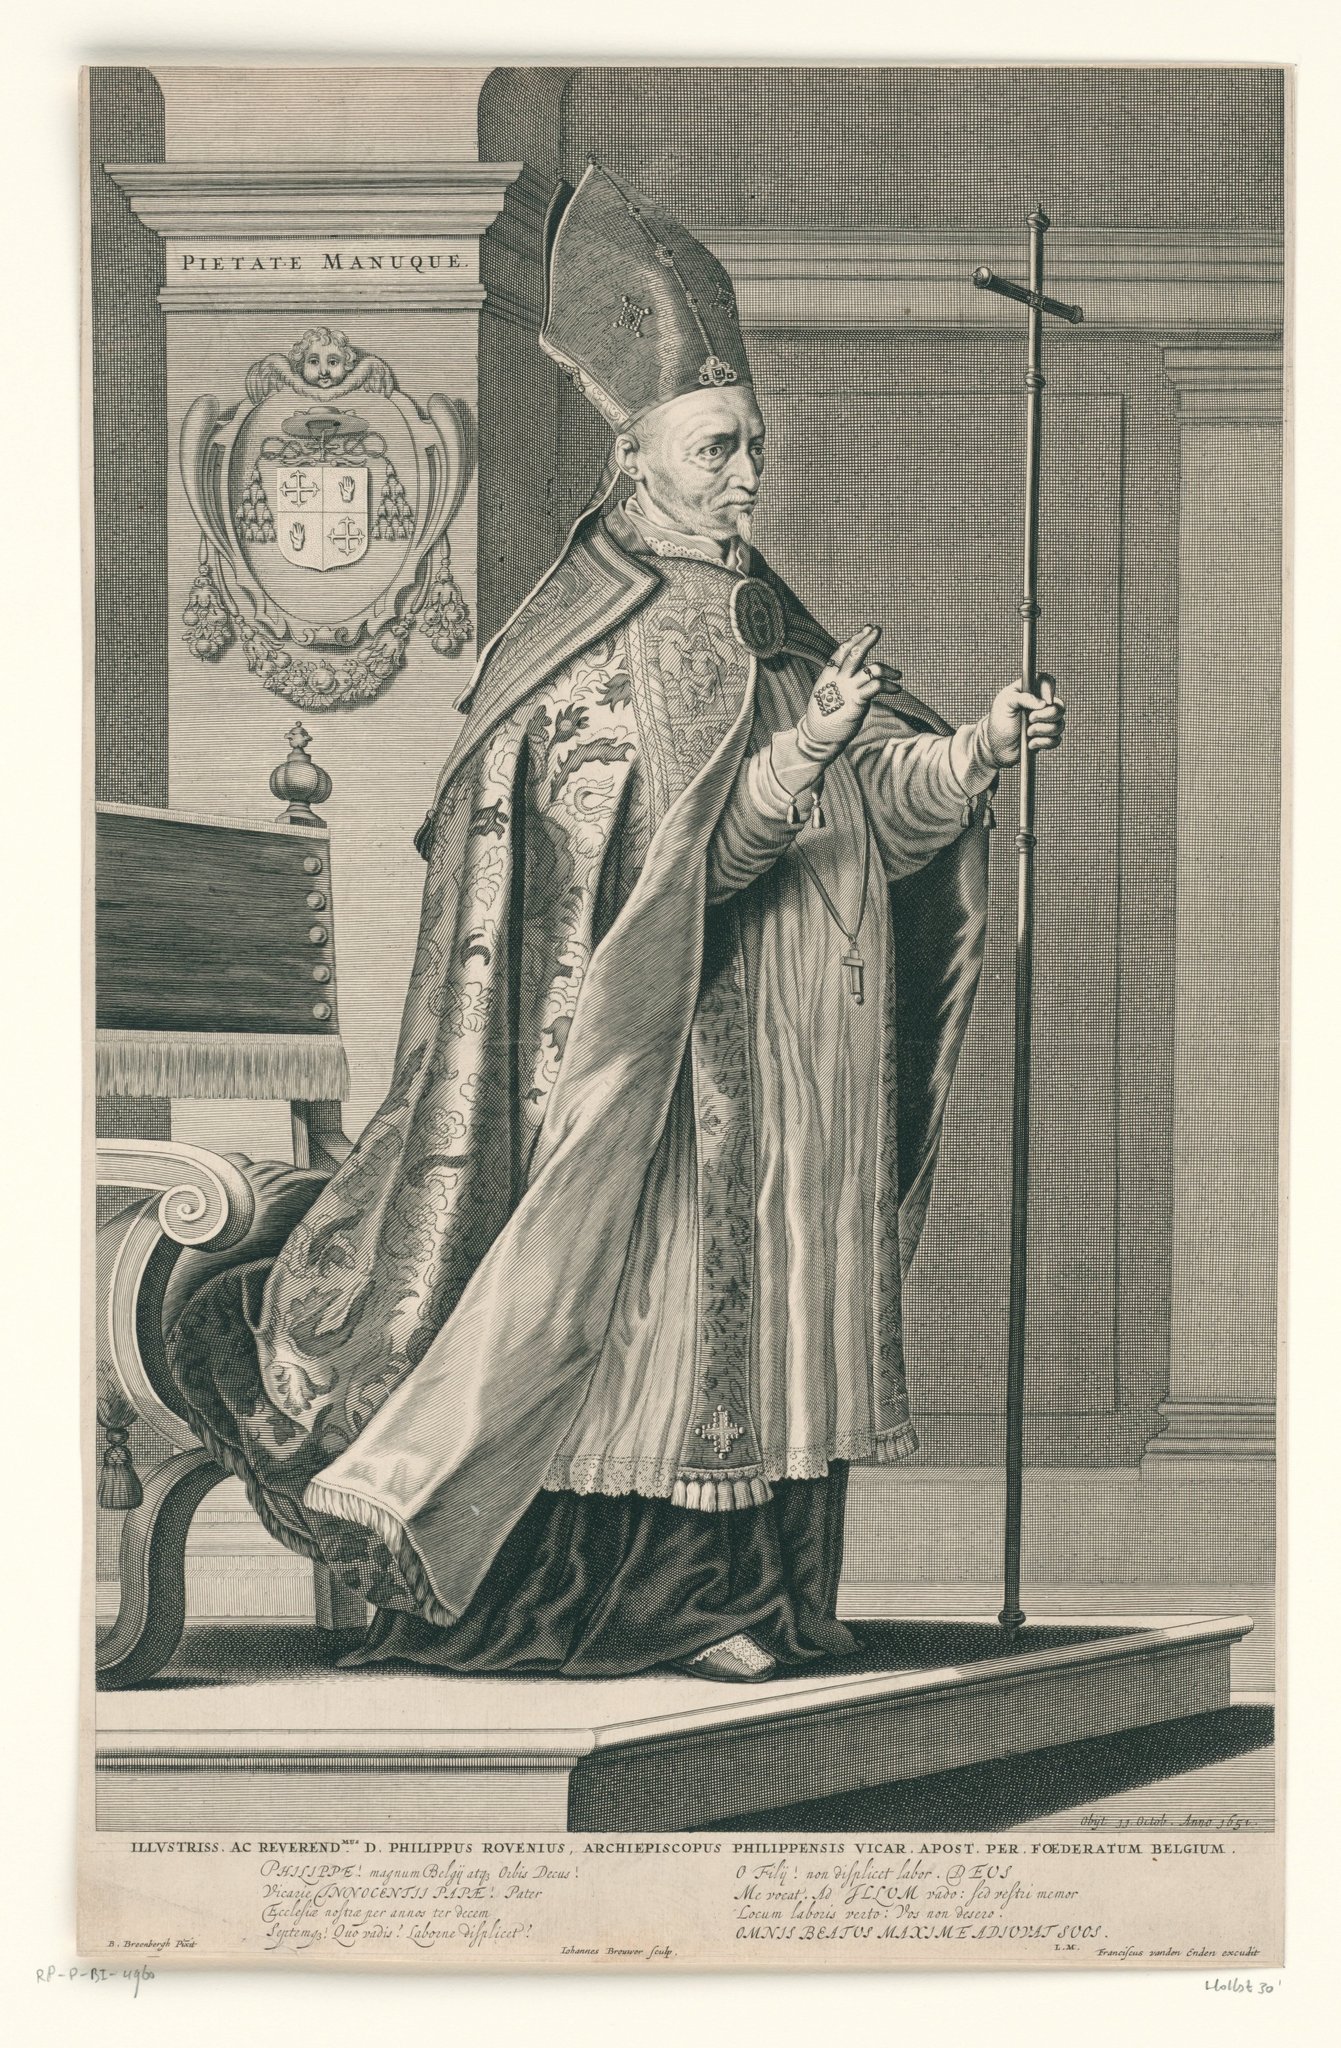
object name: print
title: Philippus Rovenius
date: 1651-1675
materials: paper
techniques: engraving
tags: deventer, utrecht, clergyman, archbishop, bishop, etc. (roman catholic), insignia of bishop, e.g. mitre, crozier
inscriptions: collector's mark: Lugt 2228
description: Portret van de Utrechtse aartsbisschop Filips van Rouveen ten voeten uit. Rouveen houdt een kruis in zijn hand en maakt een zegenend gebaar. Hij draagt de kledij van een bisschop. Op de muur op een pilaar zijn motto: 'Pietate manuque'.